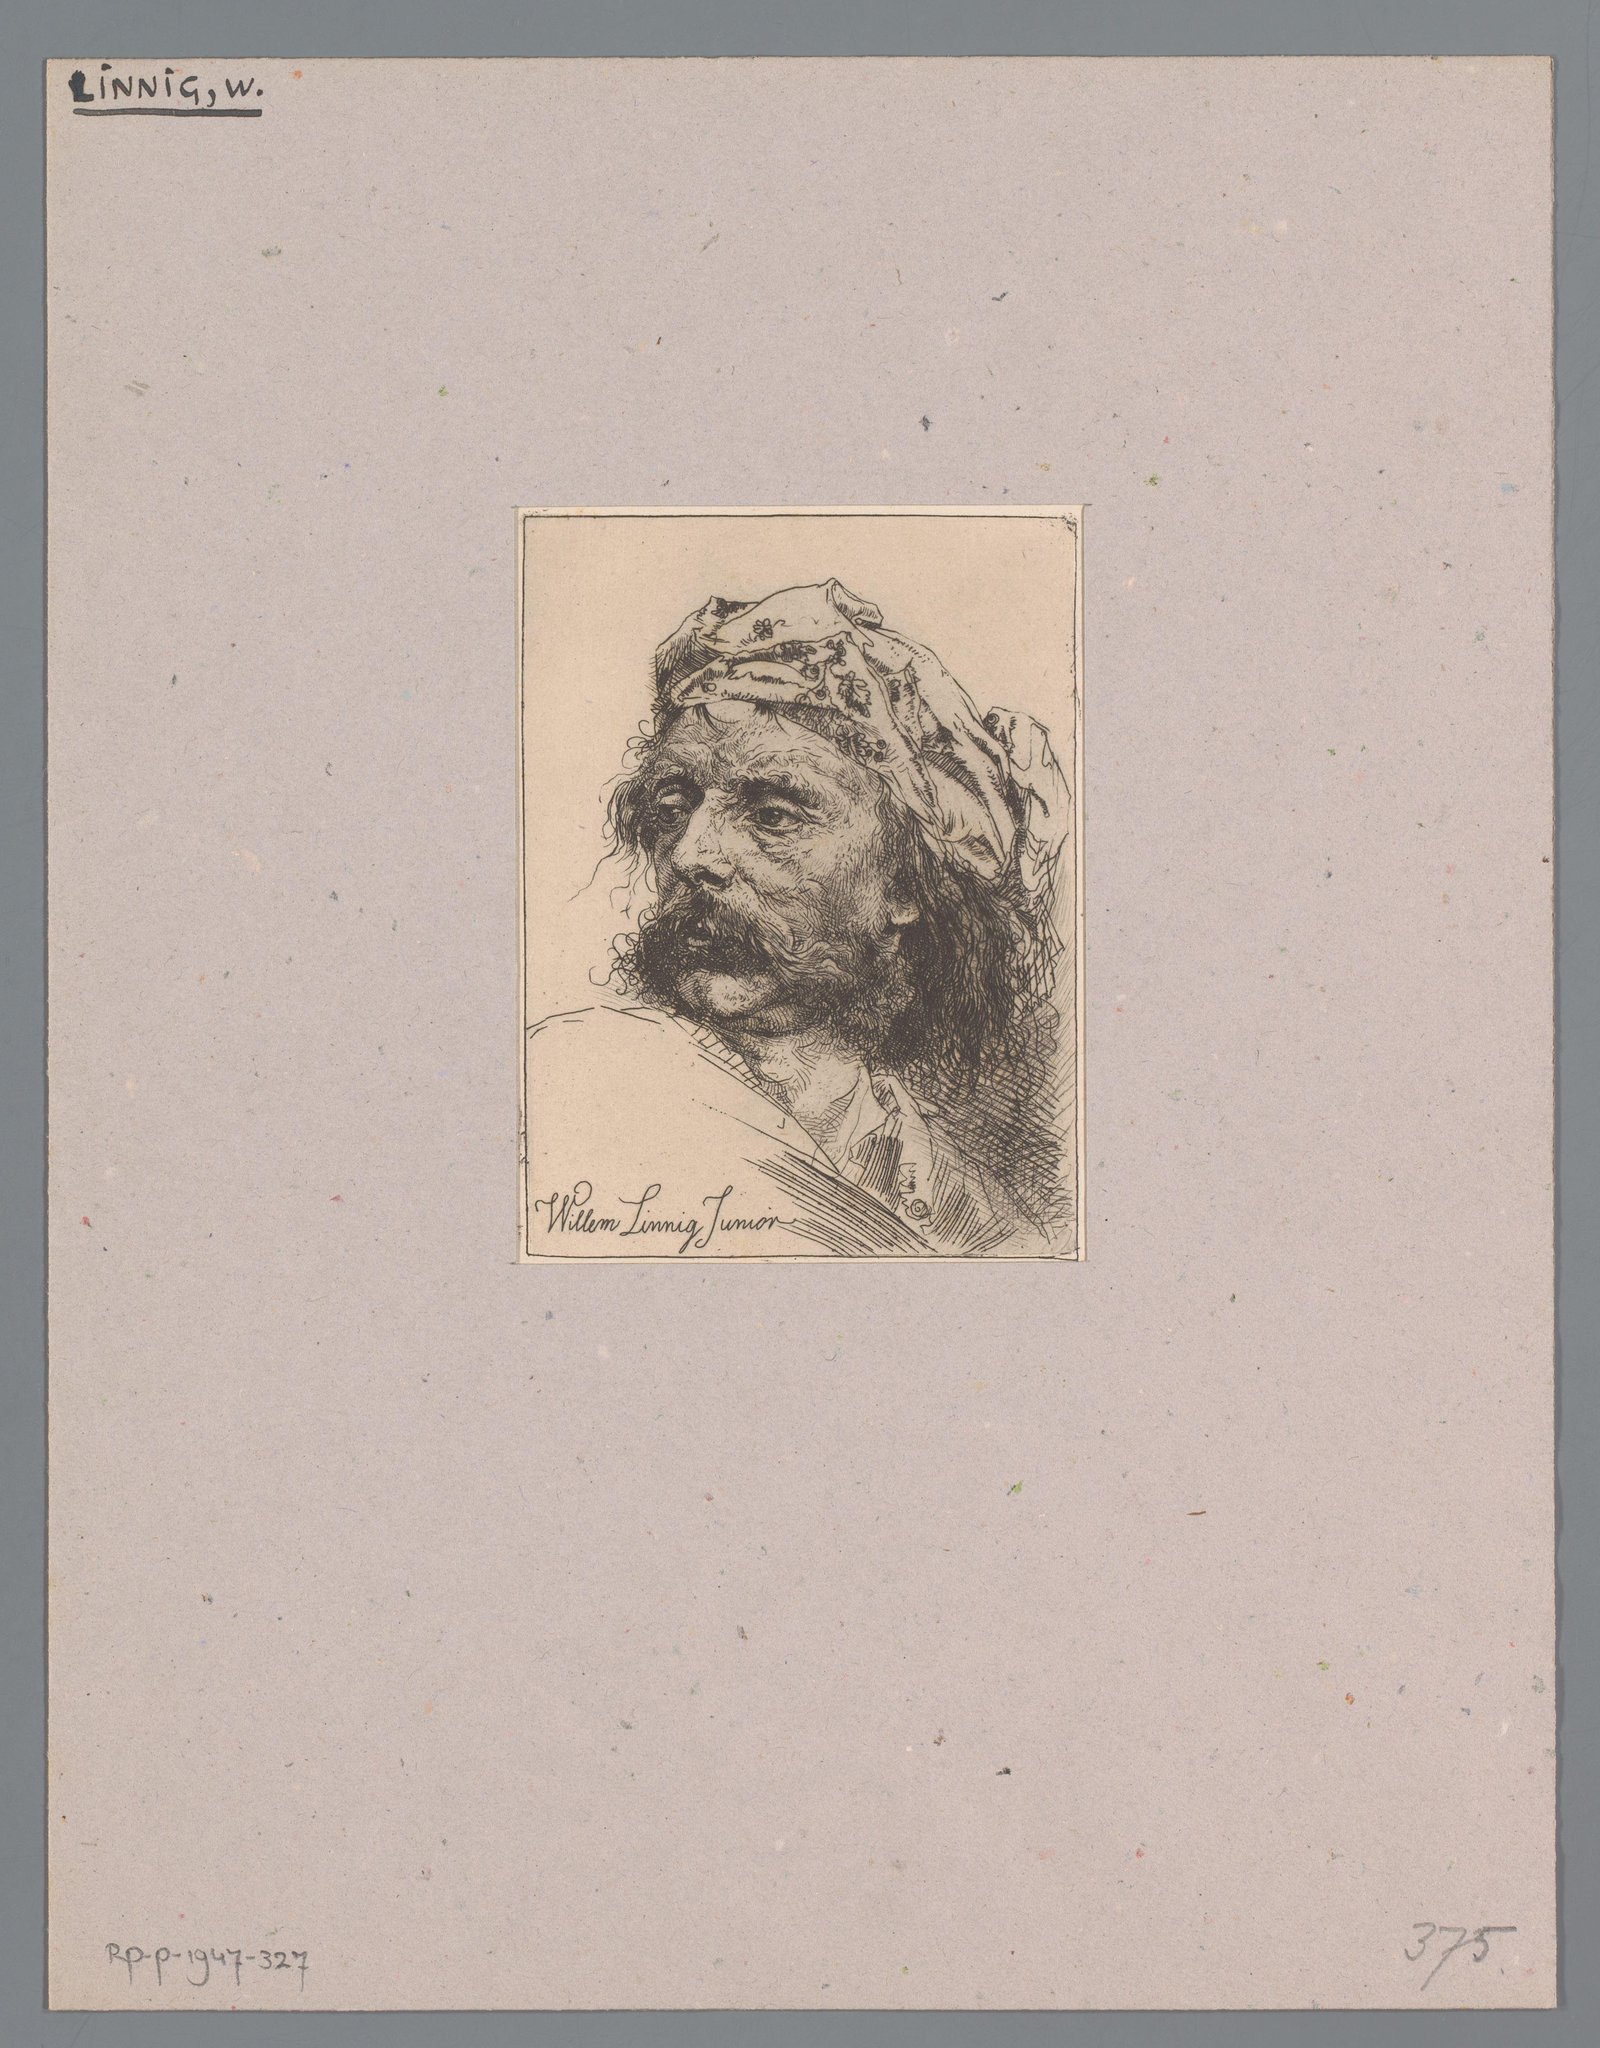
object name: print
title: Portret van een onbekende man met een hoofddoek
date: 1852-1890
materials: paper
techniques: etching, intaglio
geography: leipzig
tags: anonymous historical person portrayed alone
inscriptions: annotation: ‘Z.B.K. 1882 p. 132’, collector's mark: Lugt 2228